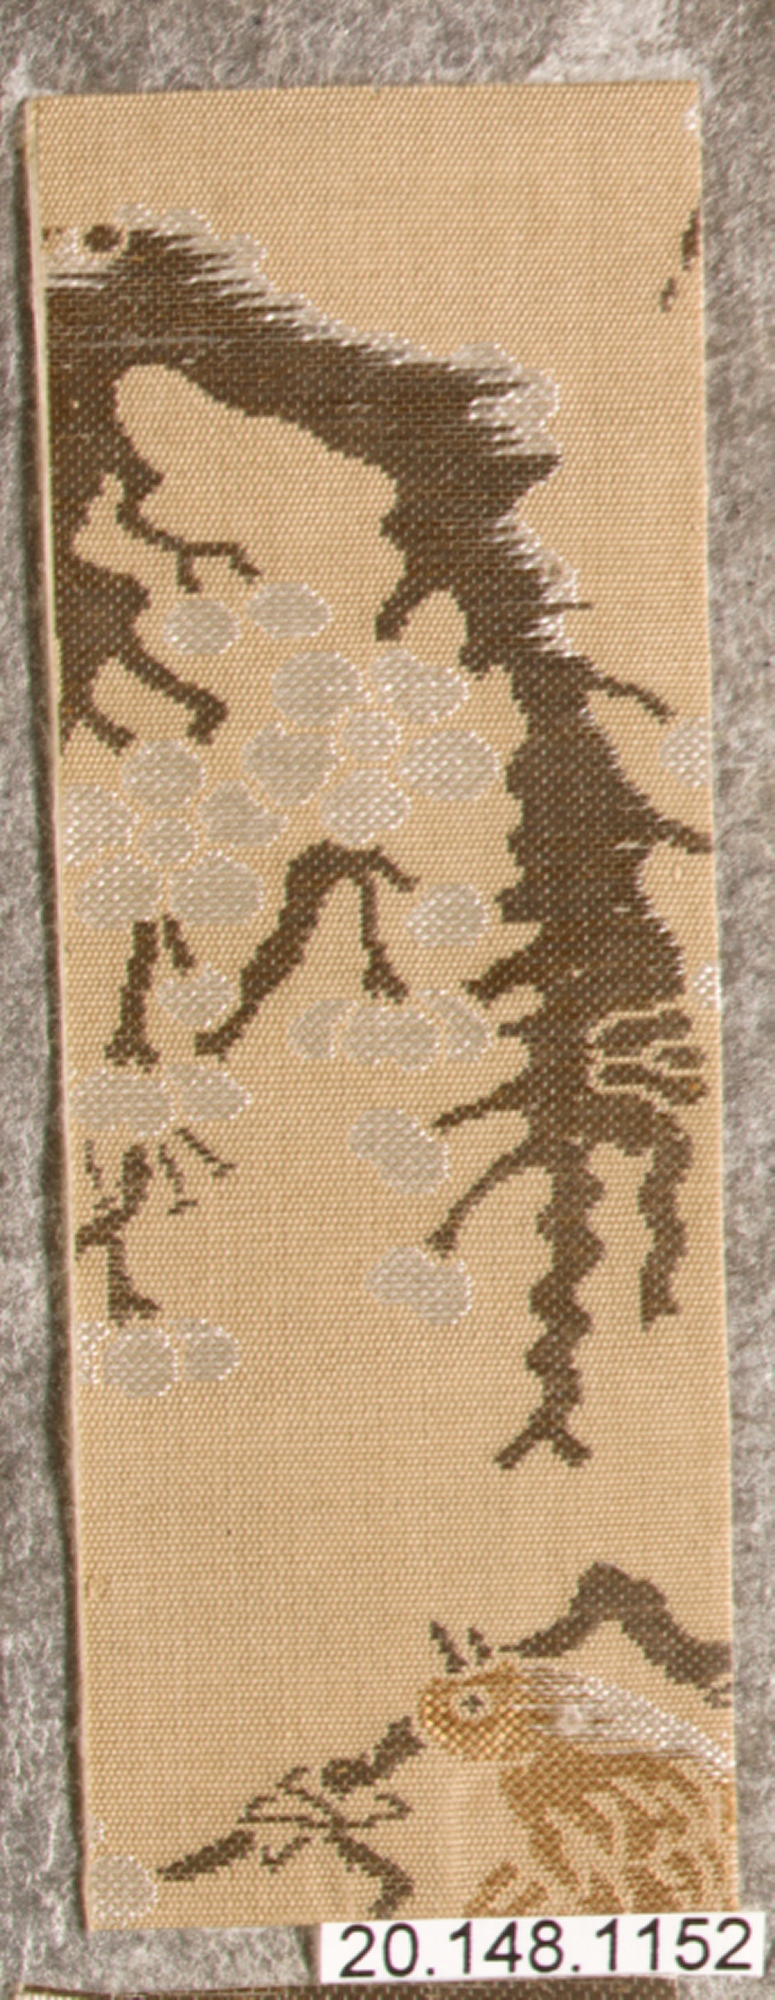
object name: piece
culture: japanese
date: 1801-1900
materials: silk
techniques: compound weave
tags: flowers